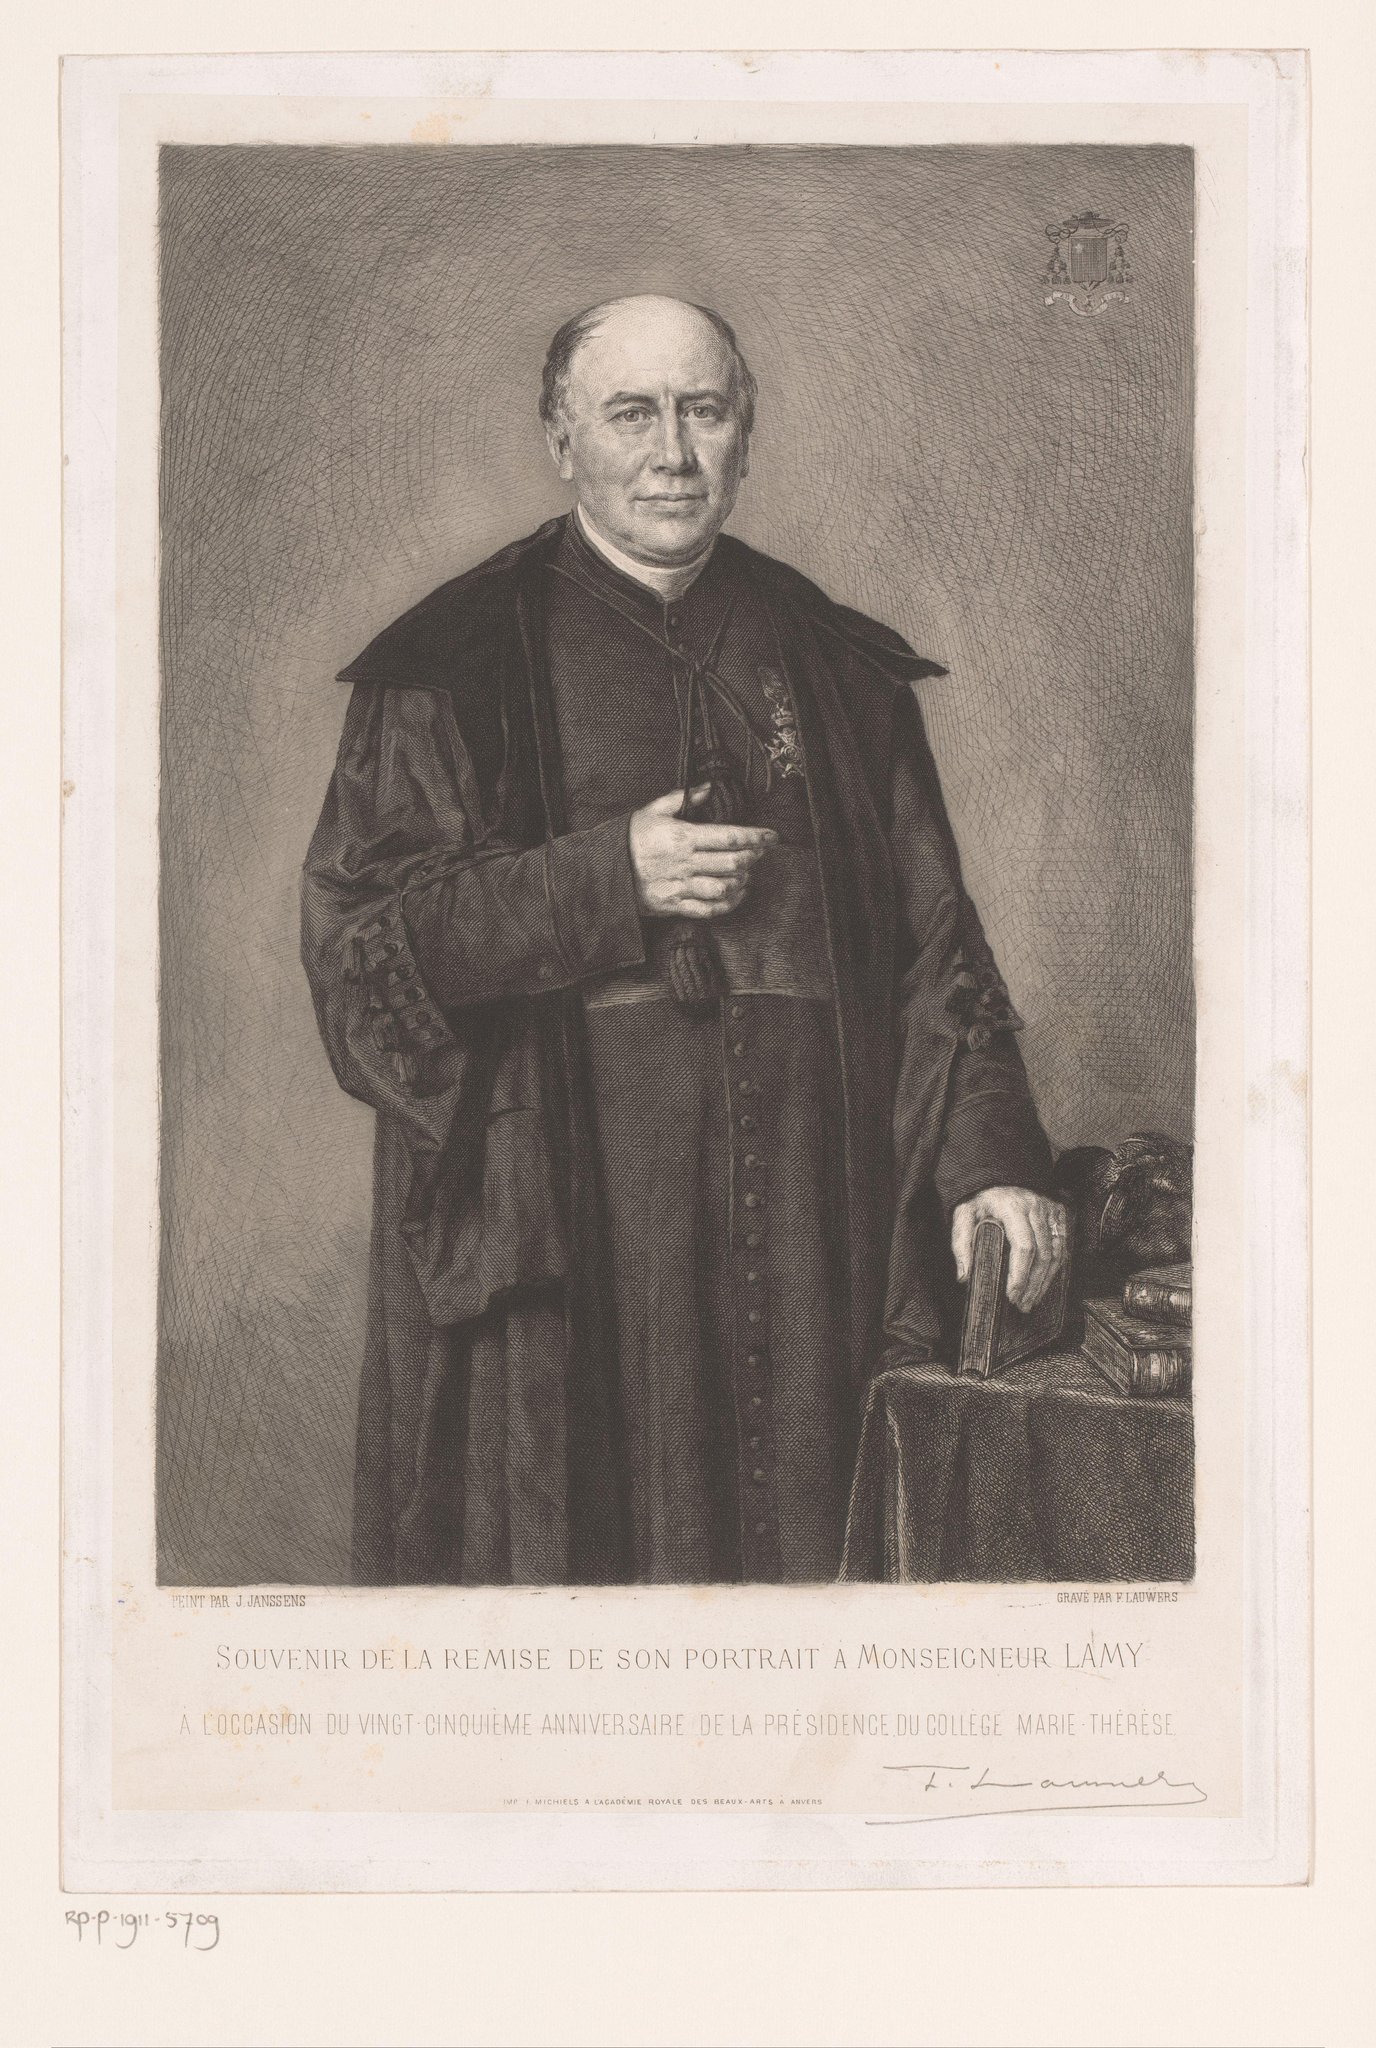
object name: print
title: Portret van een bisschop, mogelijk monseigneur Lamy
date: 1885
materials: paper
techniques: etching, intaglio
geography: antwerp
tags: archbishop, bishop, etc. (roman catholic), historical persons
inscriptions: collector's mark: Lugt 2228